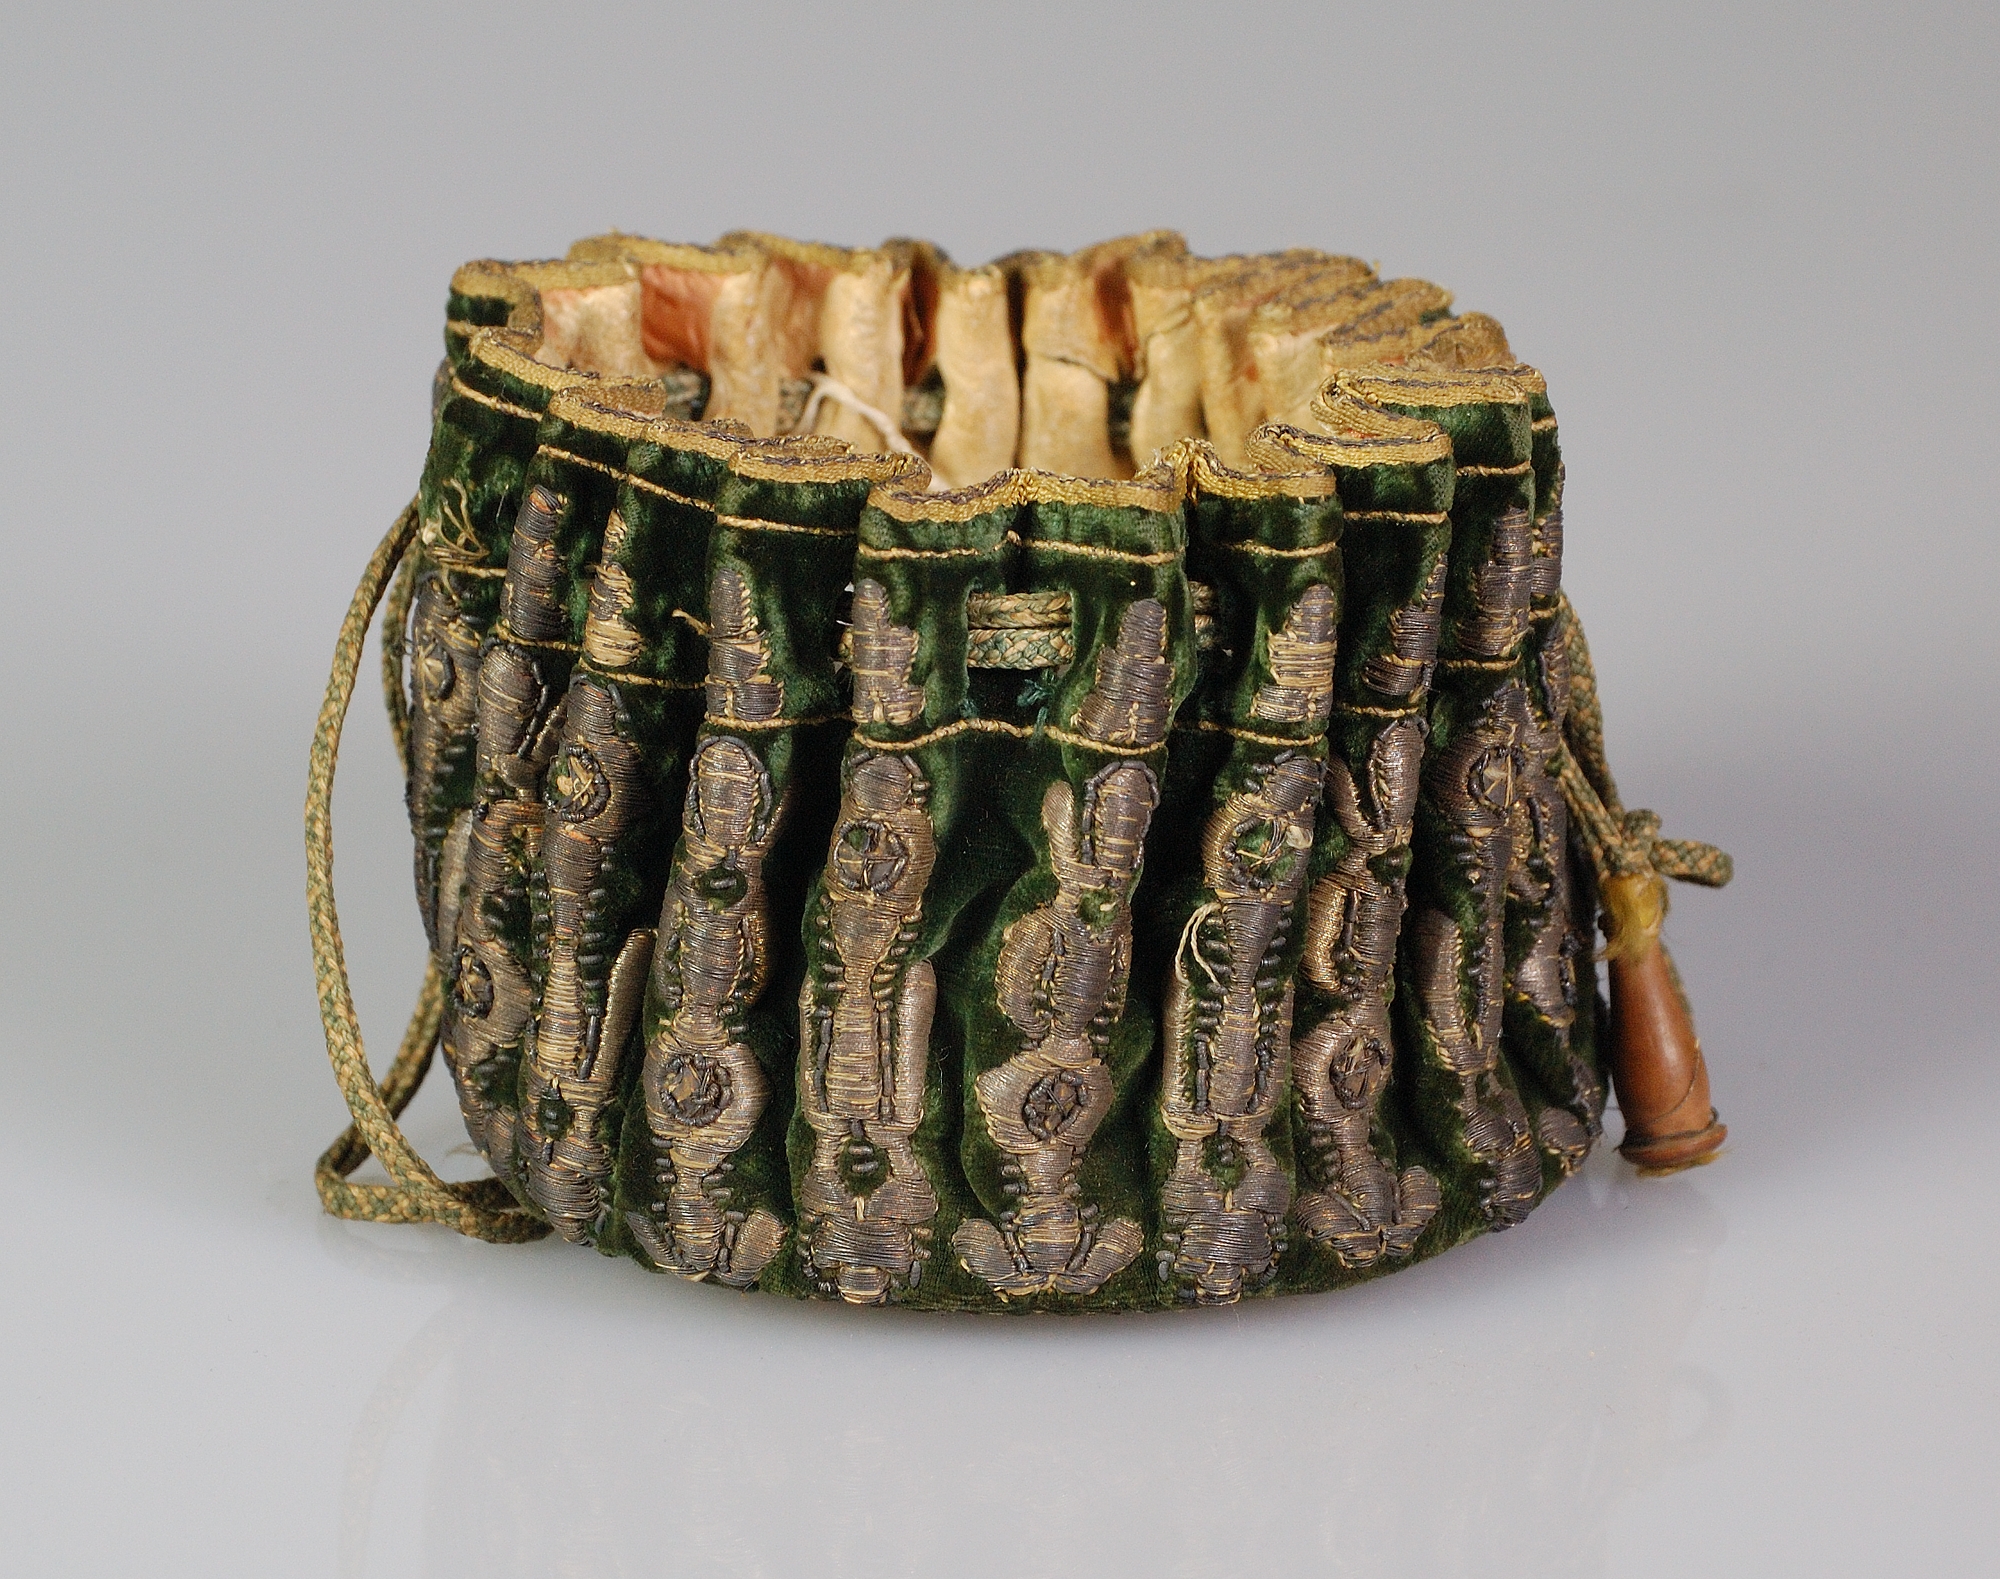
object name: gaming purse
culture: french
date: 1667-1700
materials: leather, silk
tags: gambling,games